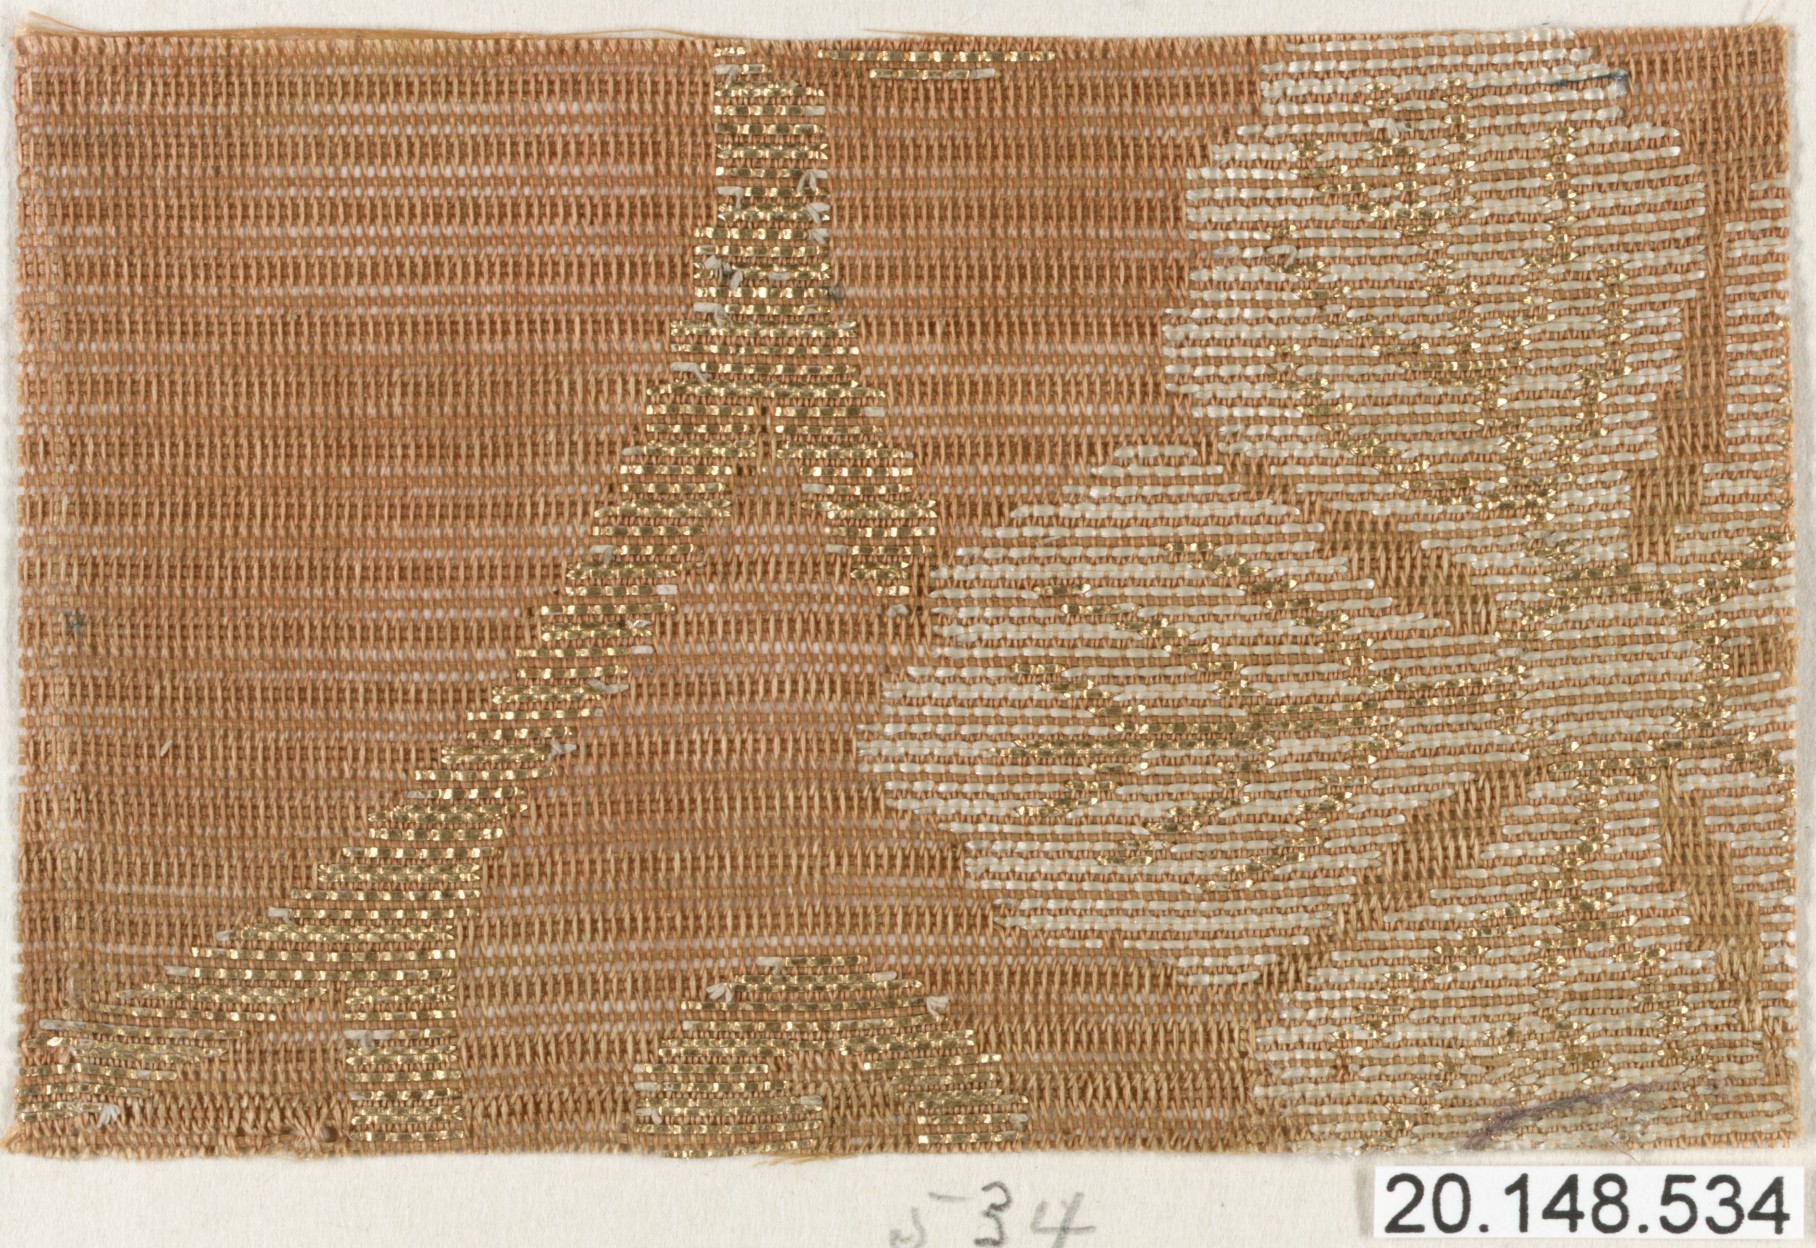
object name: piece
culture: japanese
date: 1701-1800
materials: silk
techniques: compound weave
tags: leaves